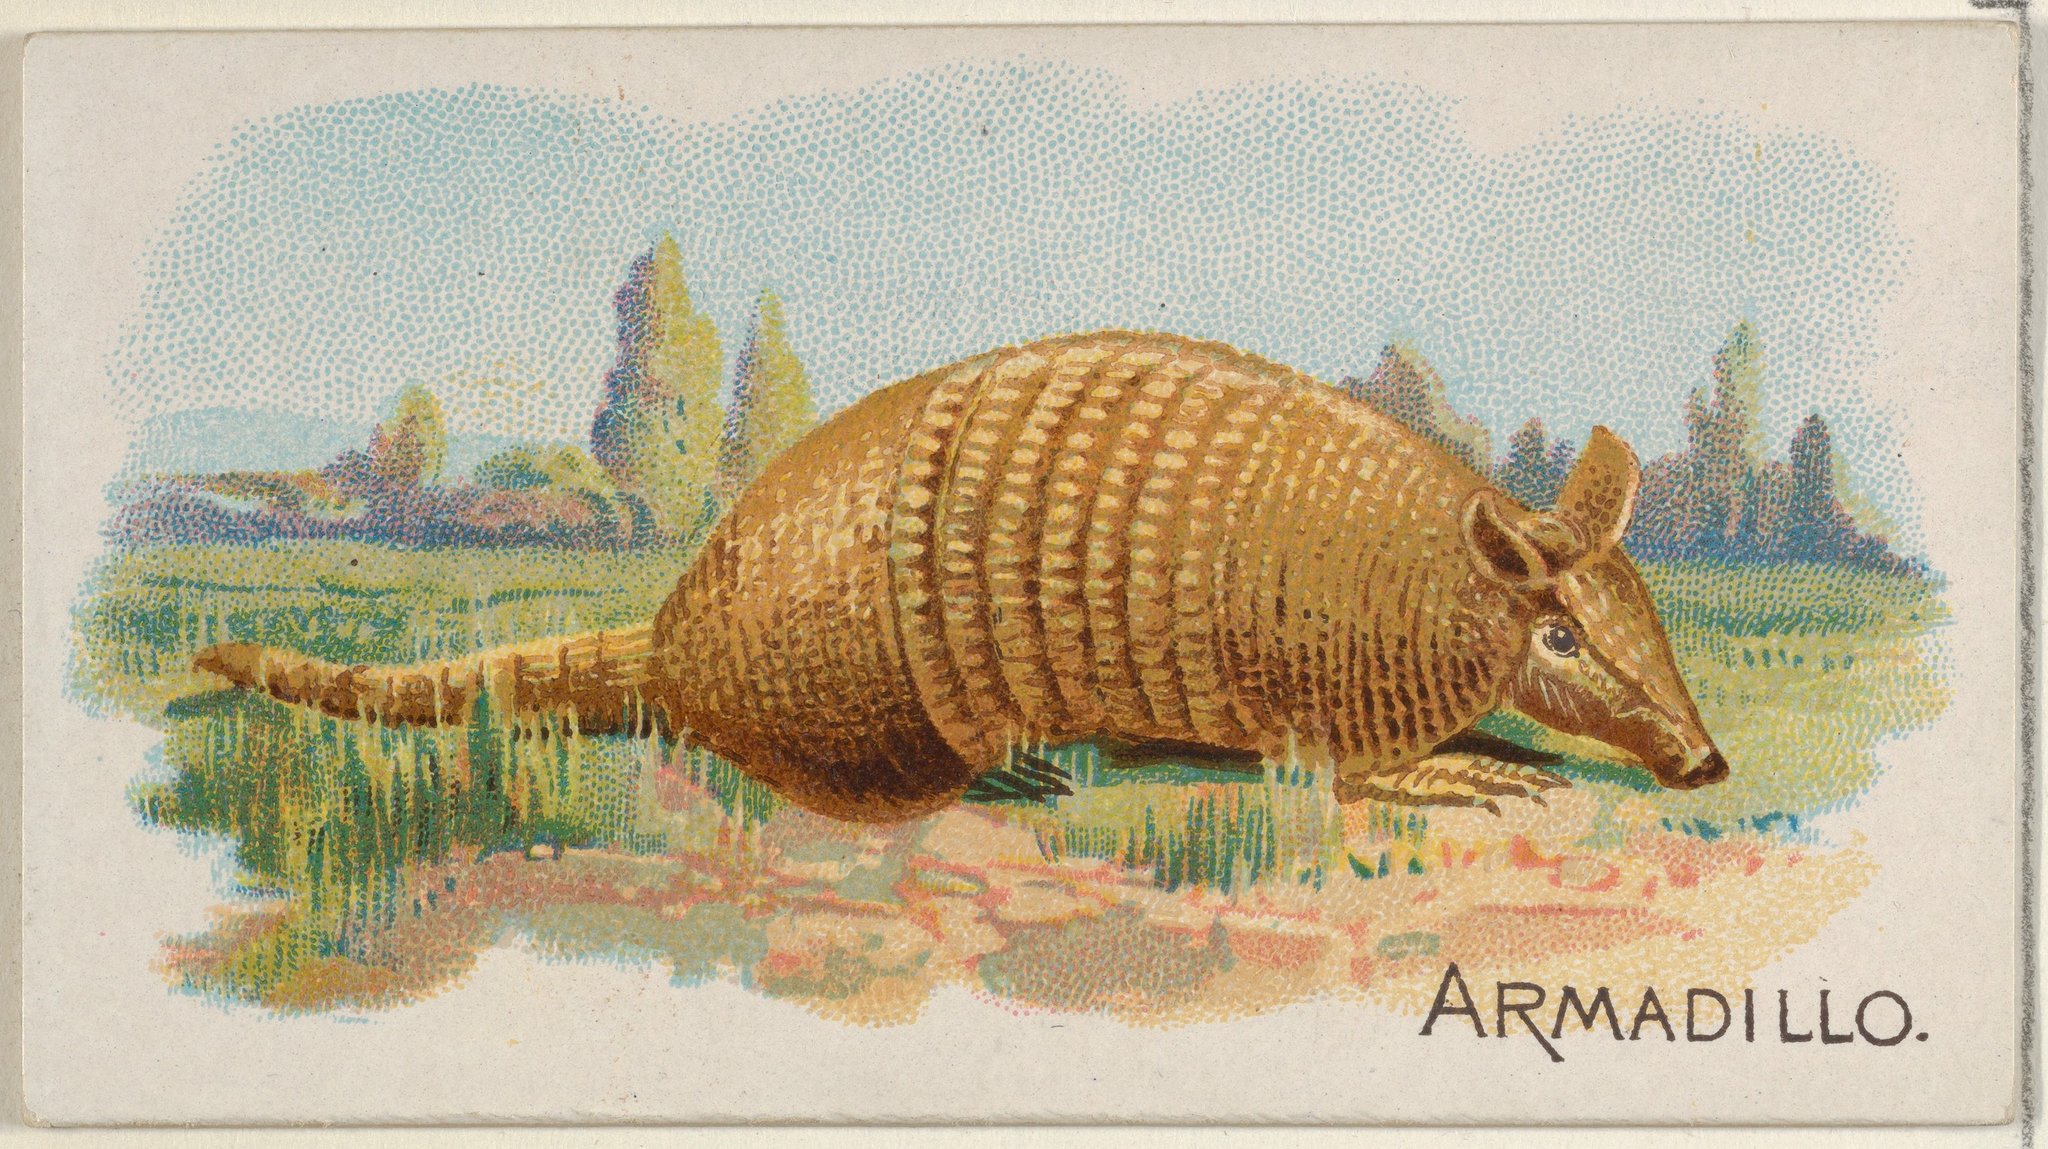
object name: print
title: Armadillo, from the Quadrupeds series (N21) for Allen & Ginter Cigarettes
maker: allen & ginter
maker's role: publisher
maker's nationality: american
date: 1890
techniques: color lithograph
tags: animals